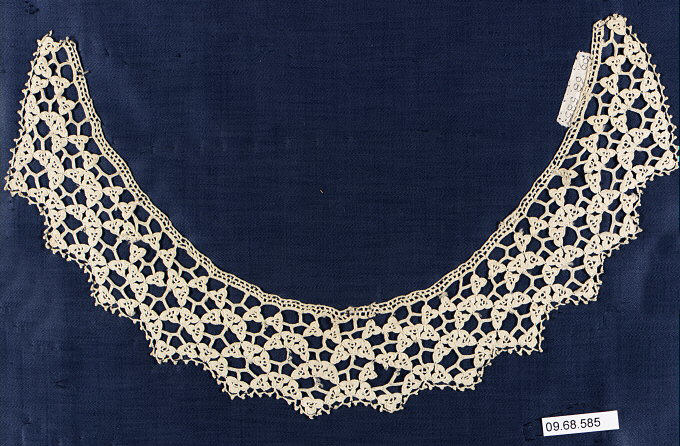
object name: collar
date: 1801-1900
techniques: crochet